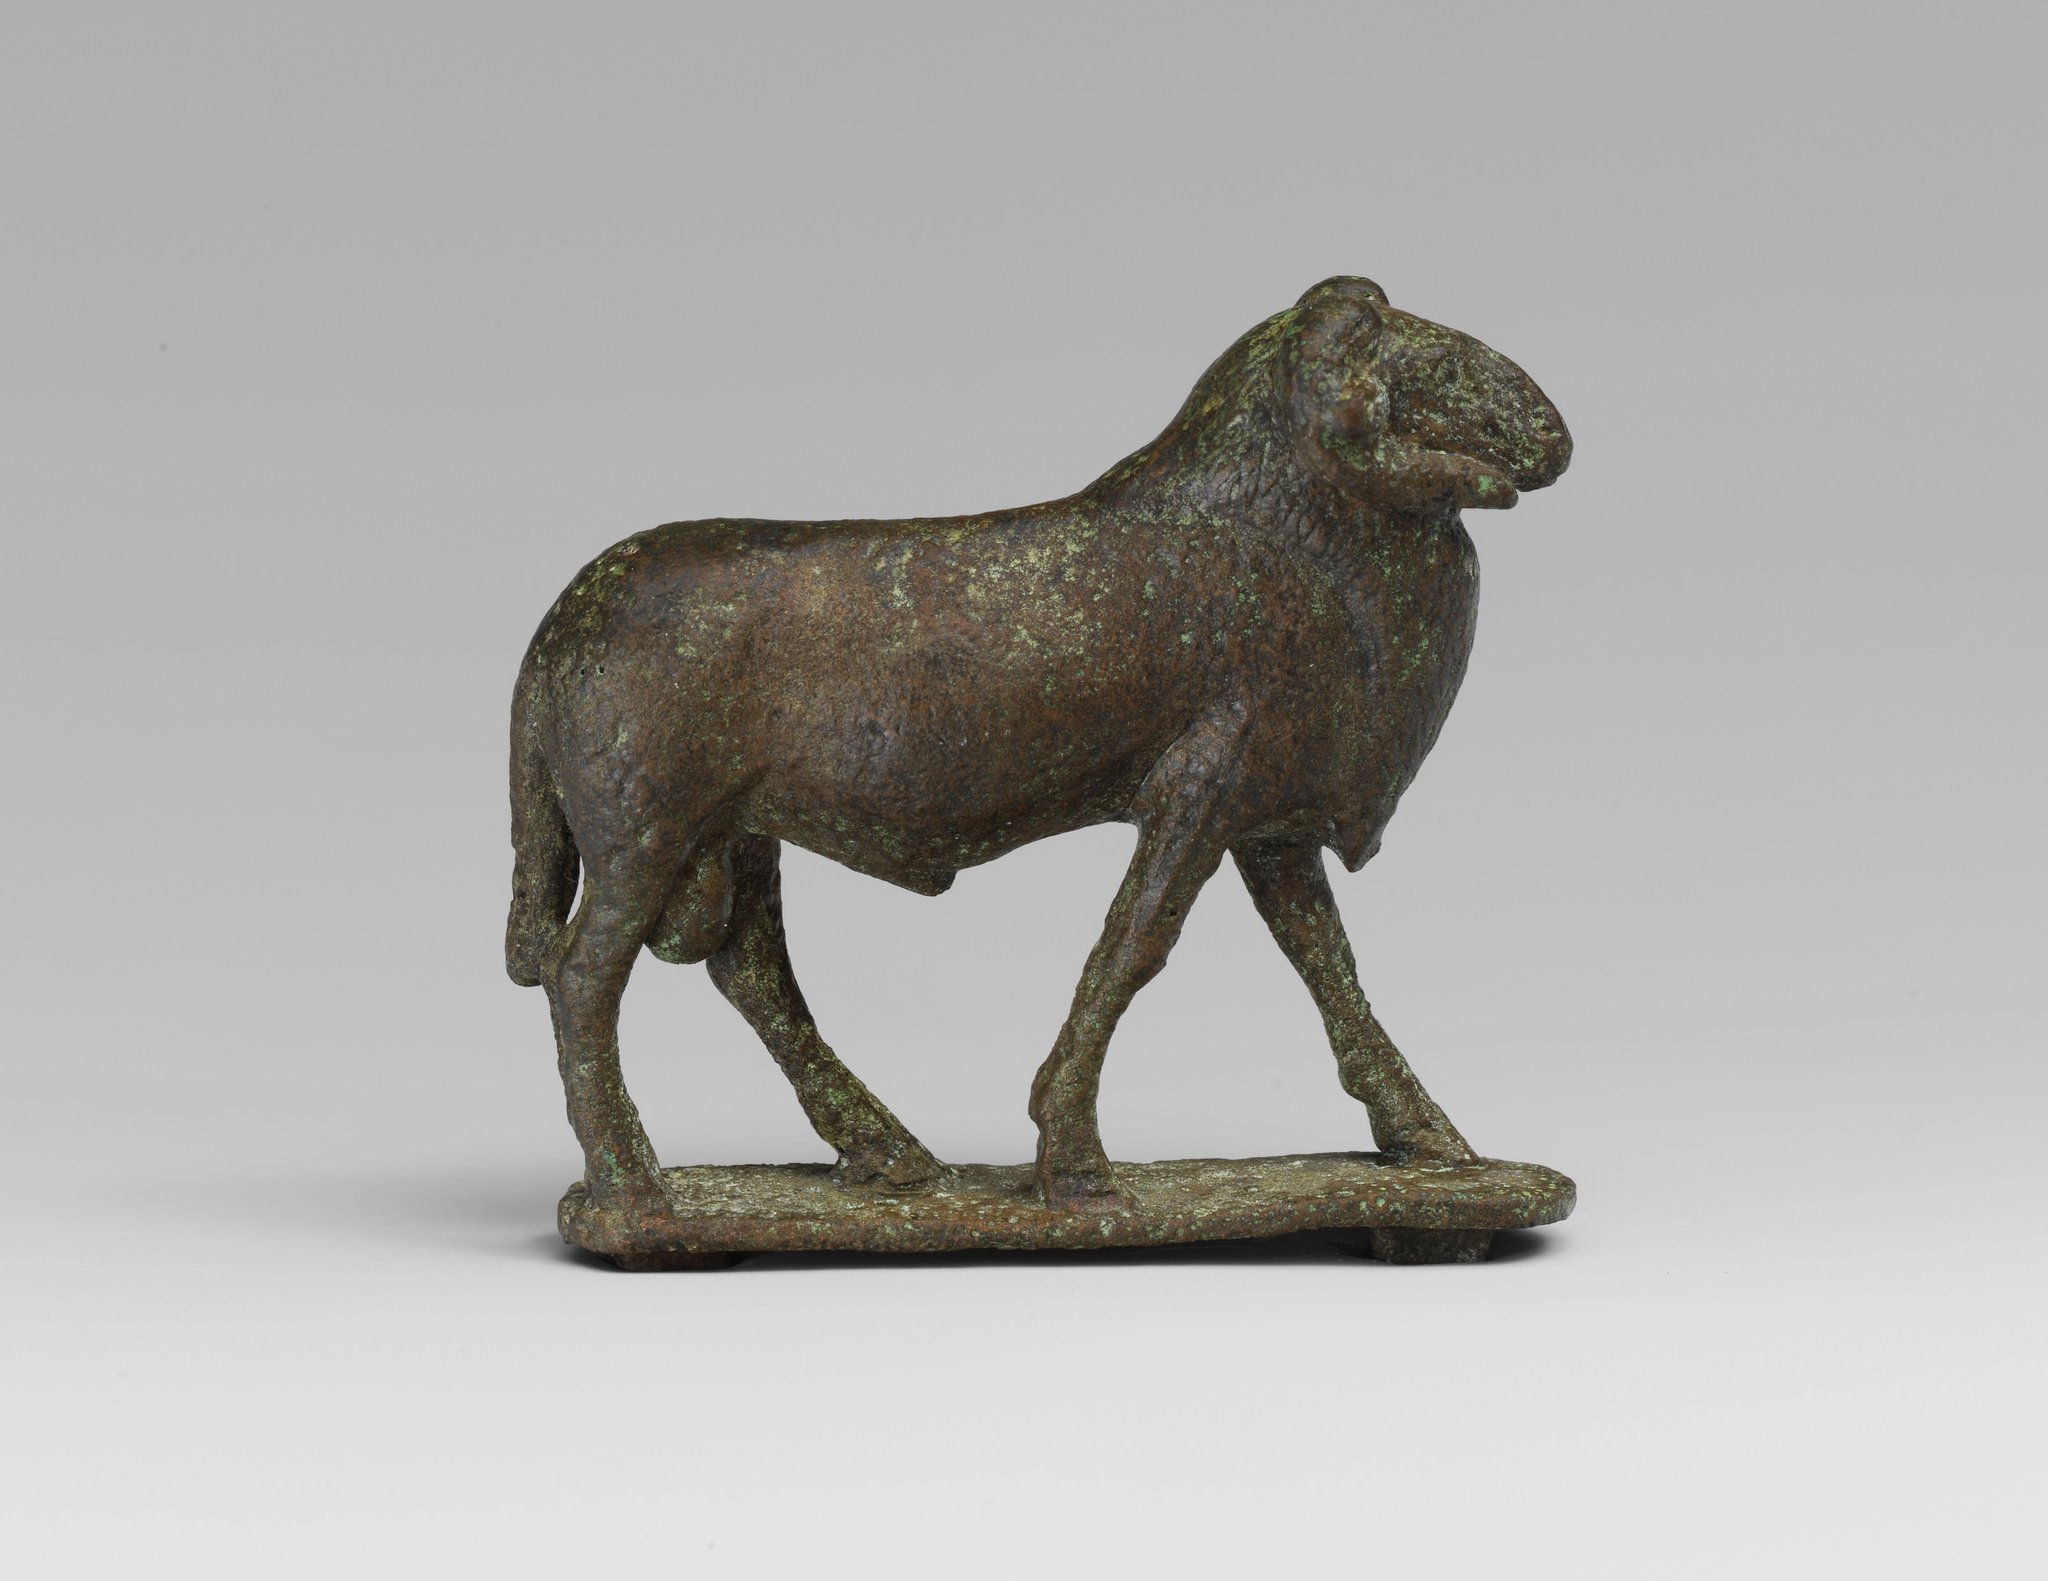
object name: statuette of a ram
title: Bronze statuette of a ram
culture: cypriot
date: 200 BCE-200 CE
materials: bronze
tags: rams